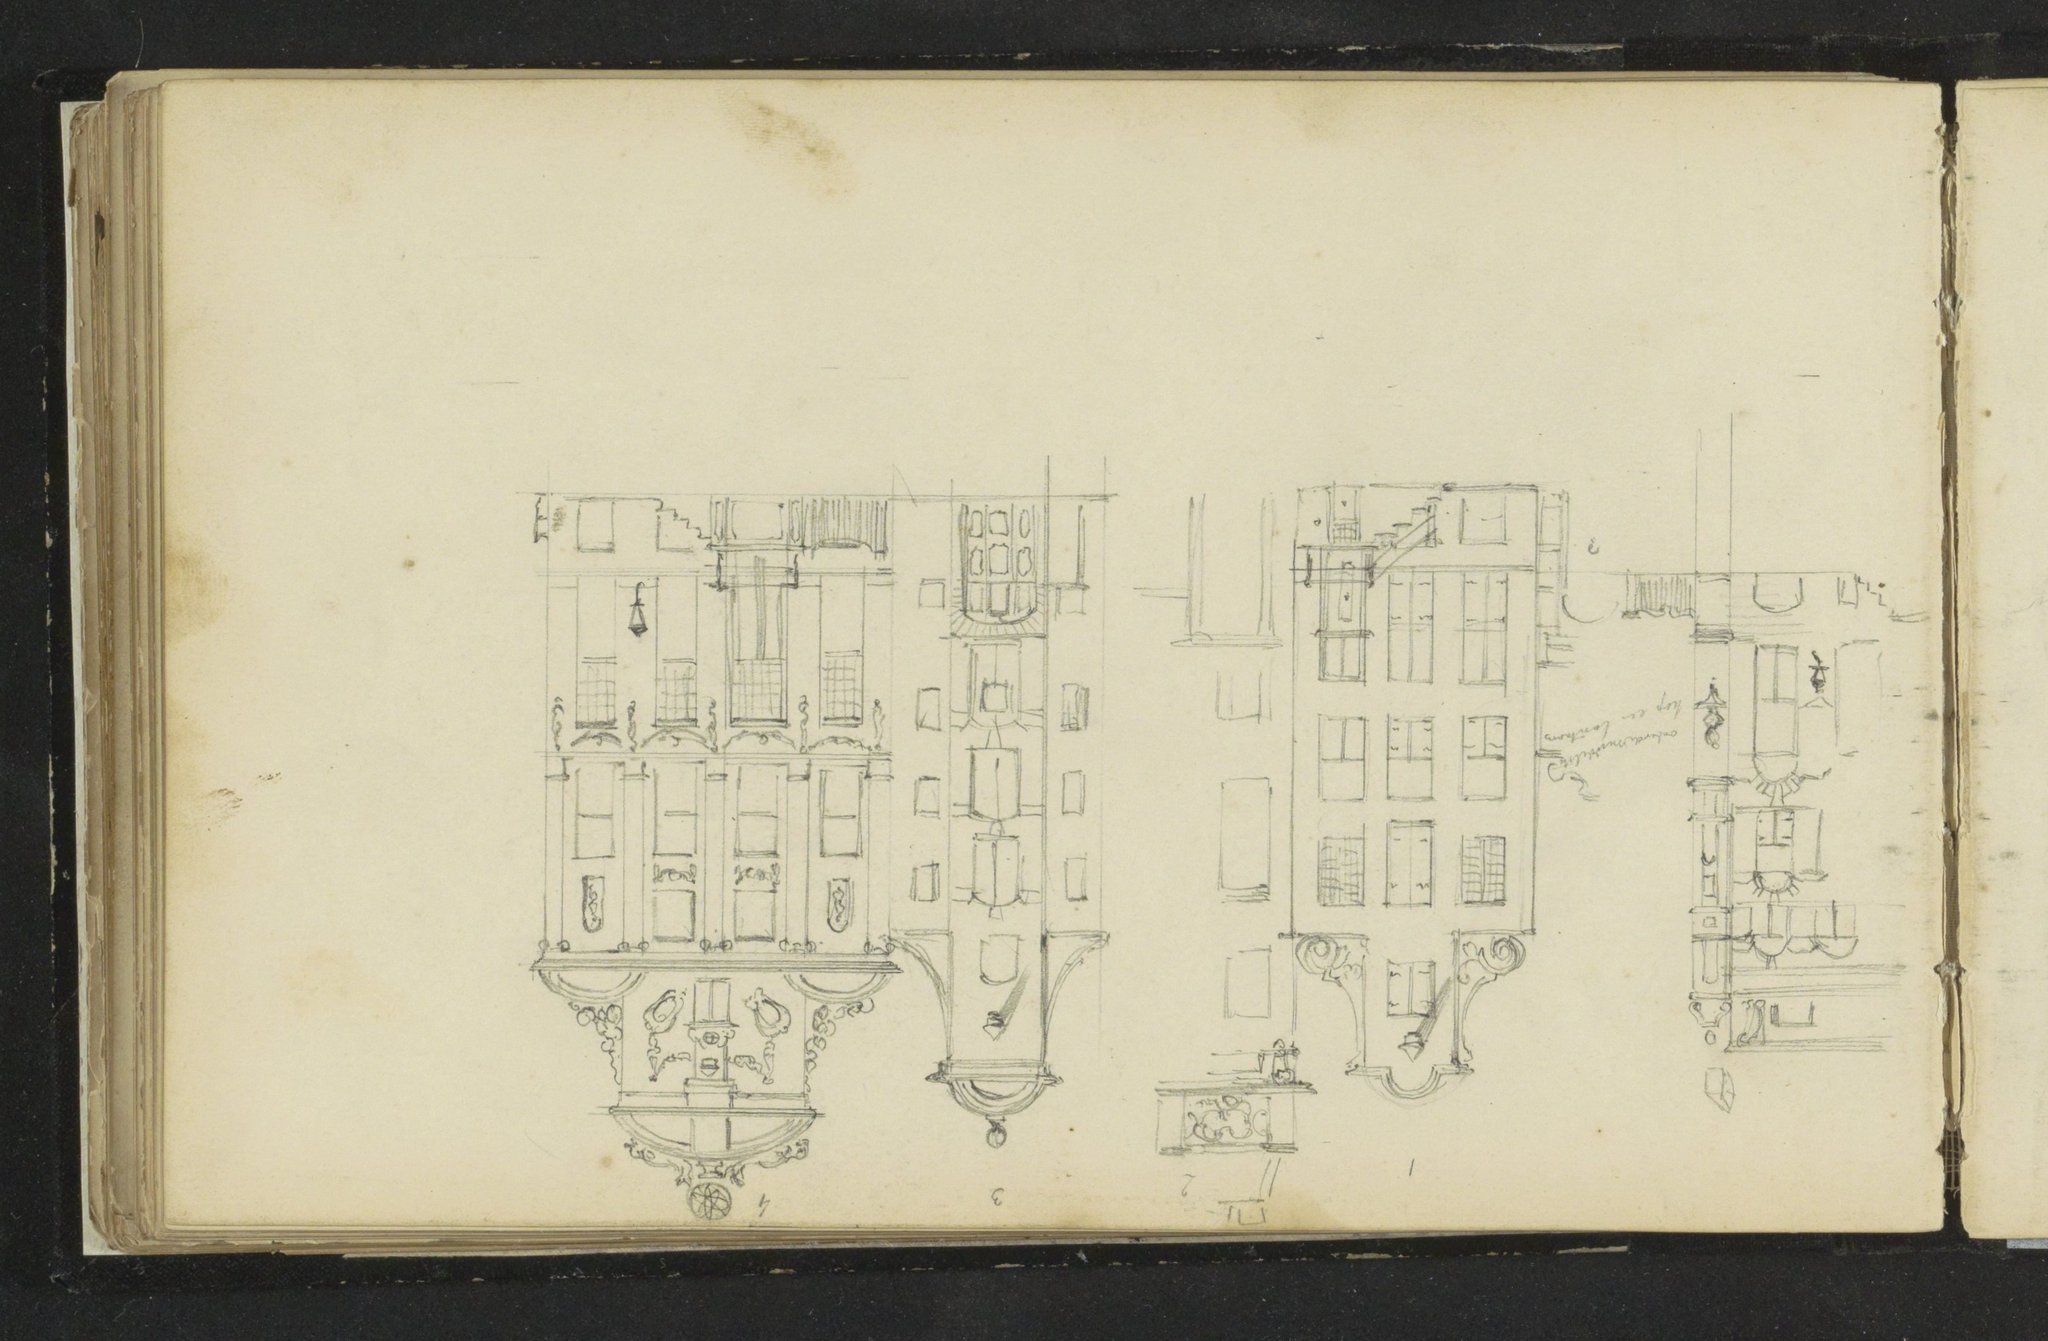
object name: sketchbook leaf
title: Vijf gevelstudies, waarschijnlijk te Amsterdam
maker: cornelis springer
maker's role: draughtsman, painter, print maker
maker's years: 1817-1891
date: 1846-1882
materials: paper, pencil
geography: amsterdam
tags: façade (of house or building), amsterdam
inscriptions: annotation: ‘1/ 2/ 3/ 4/ onder de middelste/ kop een lantaarn’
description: Vijf gevelstudies, waarschijnlijk te Amsterdam. Blad 75 verso uit een schetsboek met 91 bladen.